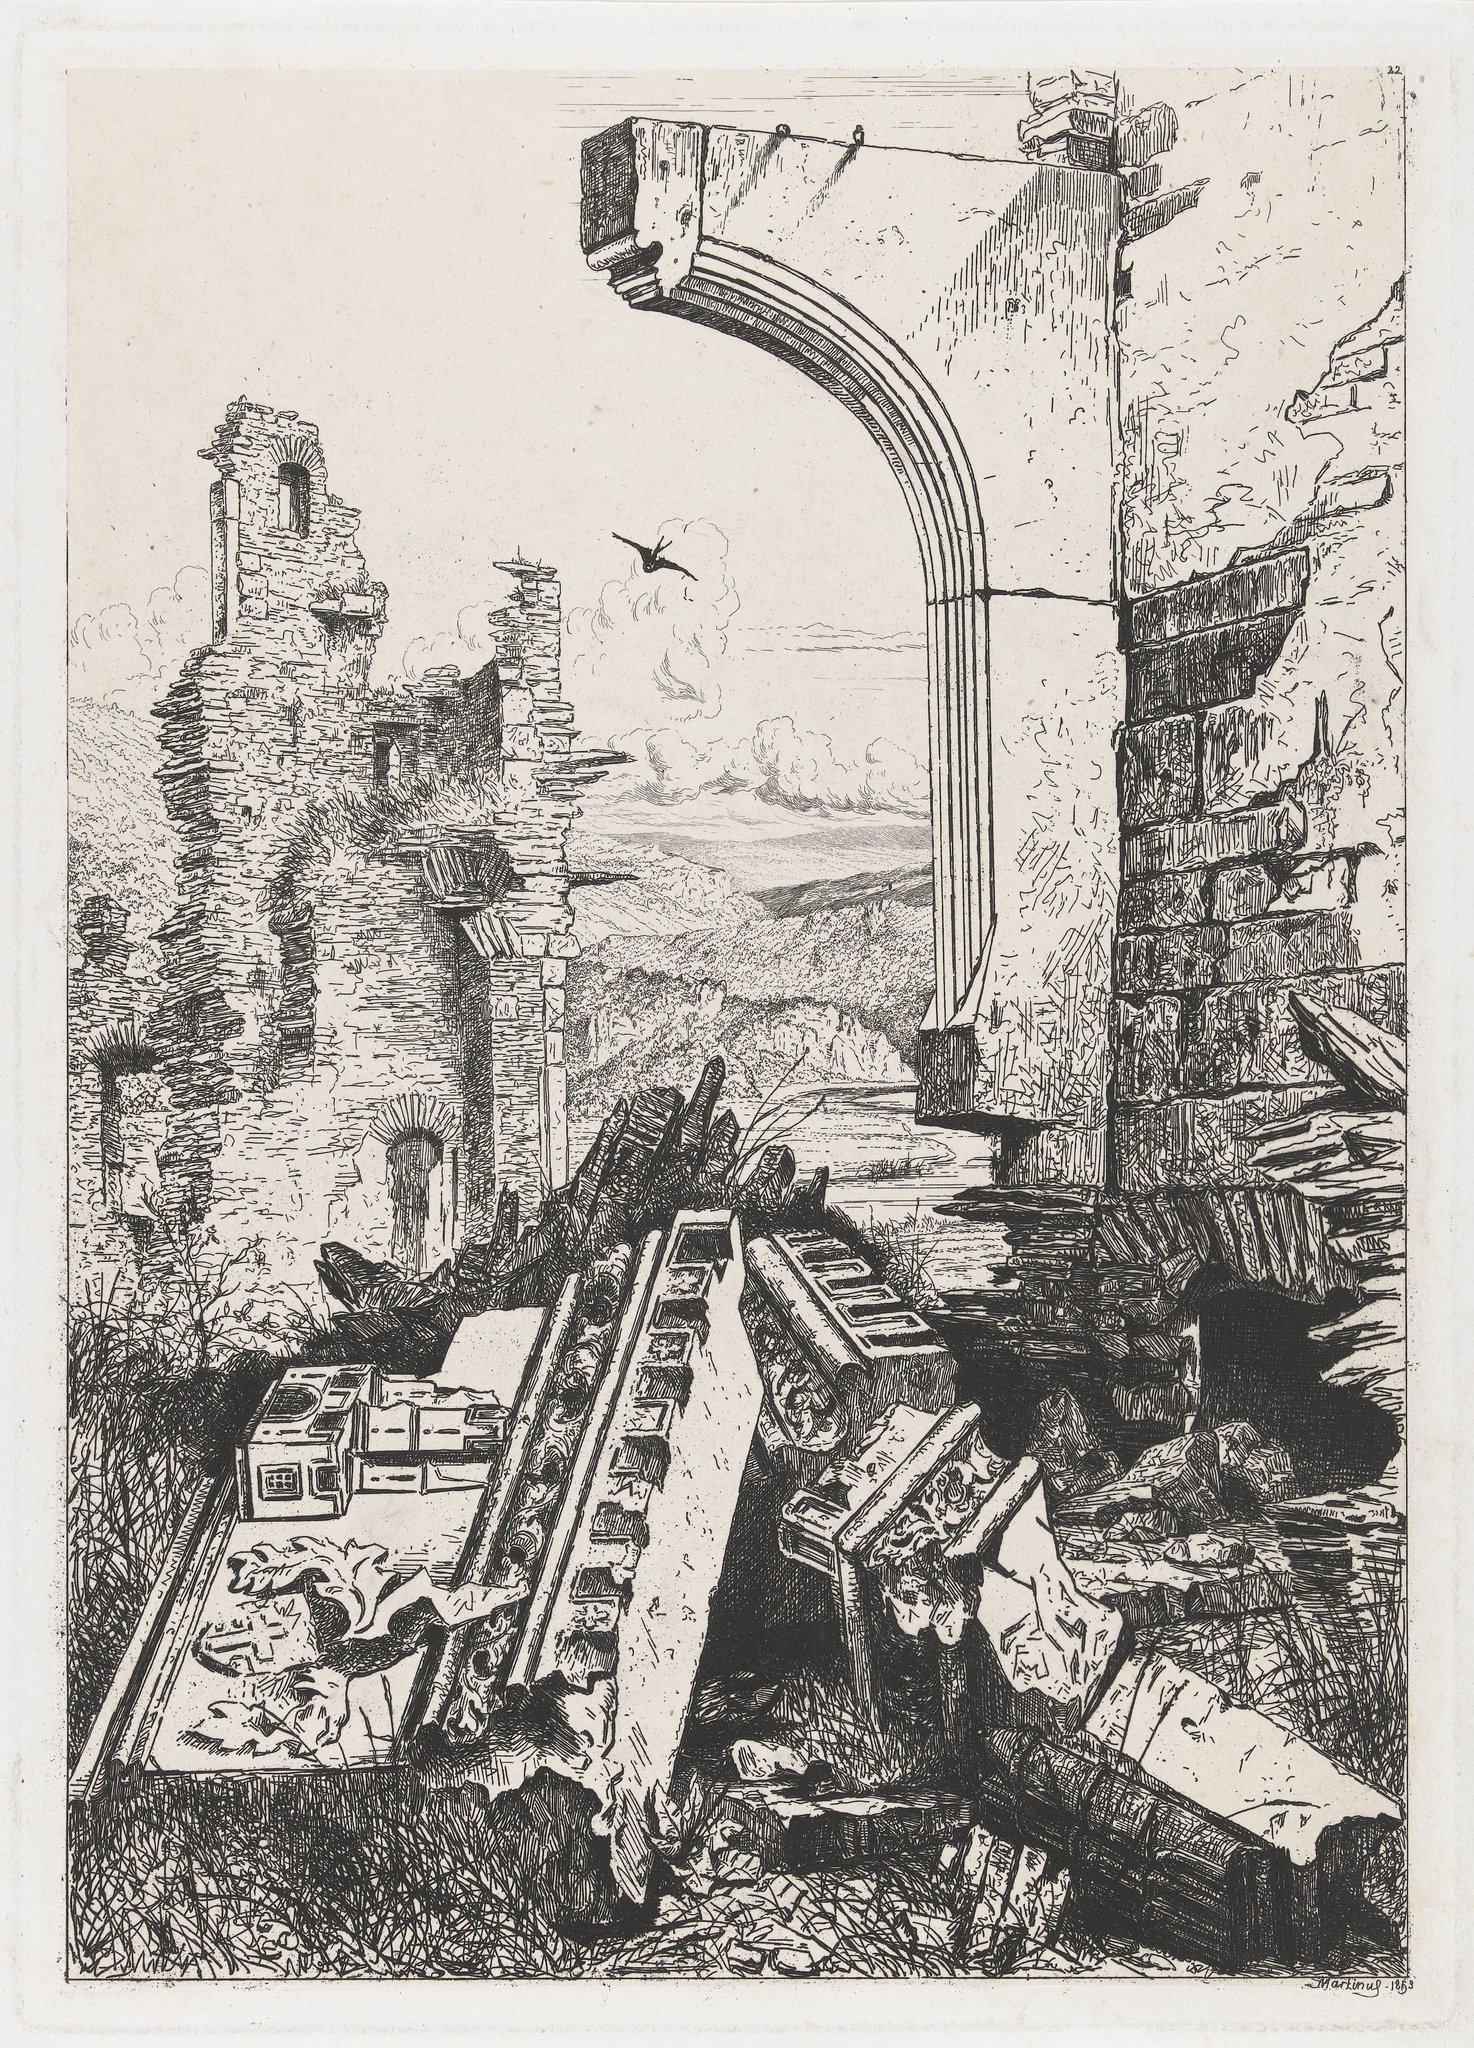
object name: print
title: Ruïne van kasteel Bourscheid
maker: martinus antonius kuytenbrouwer jr.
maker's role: draughtsman, painter, print maker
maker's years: 1821-1897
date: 1853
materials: paper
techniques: drypoint, etching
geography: brussels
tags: river, song-birds: swallow, ruin of a dwelling, house, castle, etc.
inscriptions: collector's mark: Lugt 2228, collector's mark: Lugt 1485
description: In een heuvelachtig landschap vliegt een zwaluw boven de ruïne van kasteel Bourscheid, gelegen aan de rivier de Sûre.